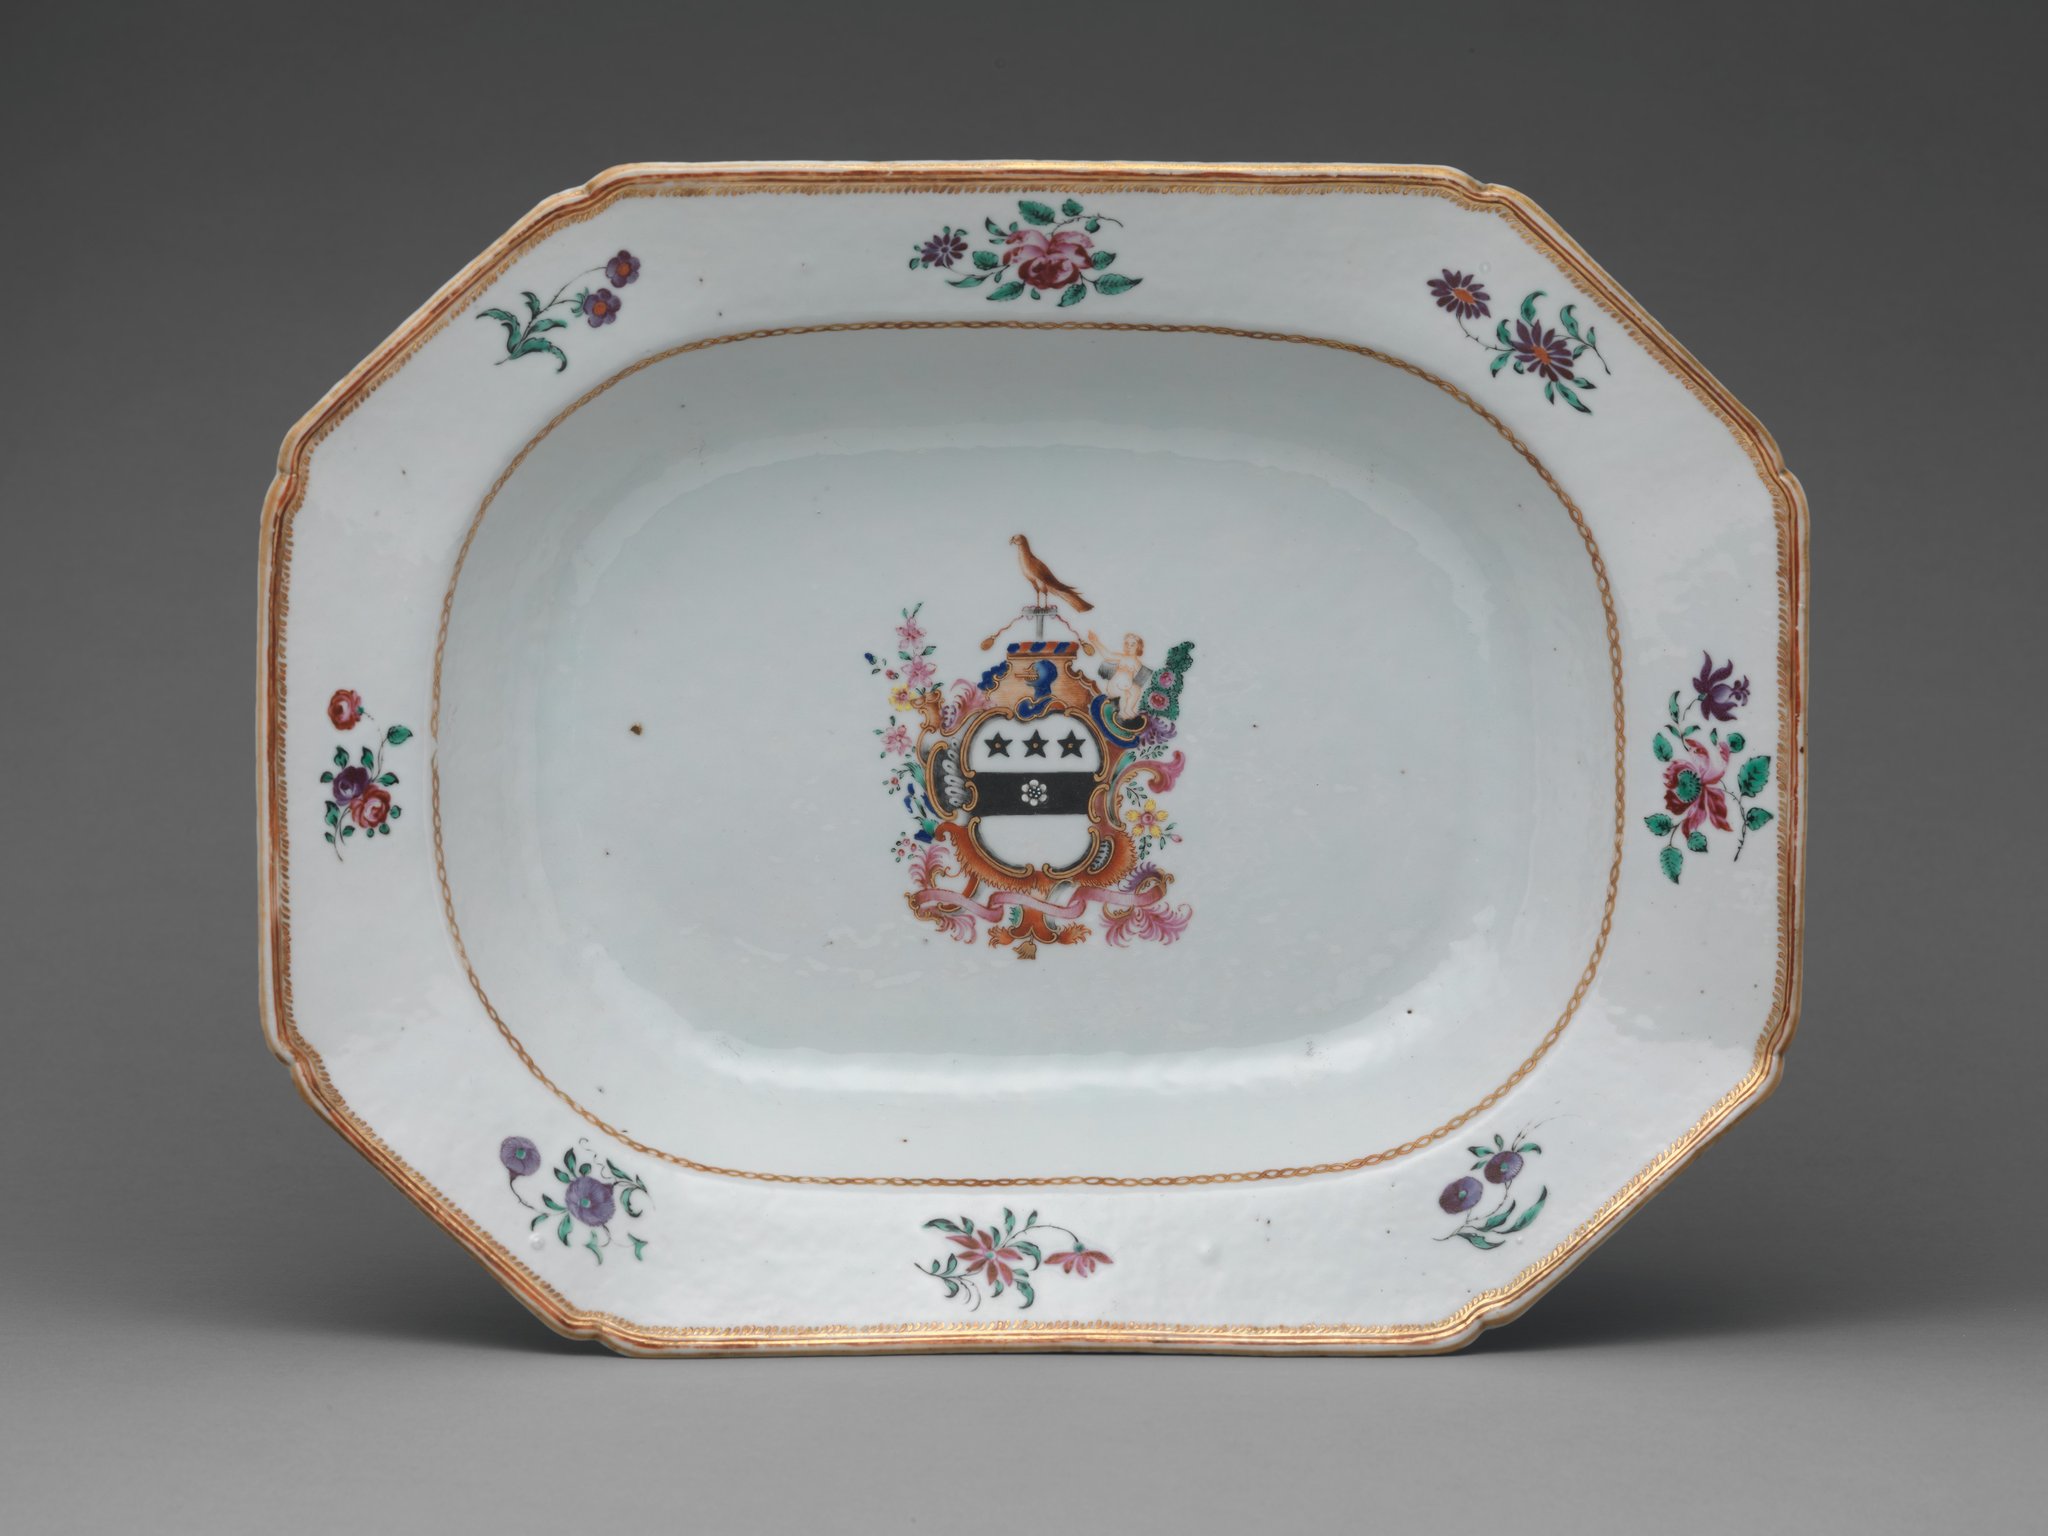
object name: platter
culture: chinese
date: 1785-1790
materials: porcelain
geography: china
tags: birds,flowers,coat of arms